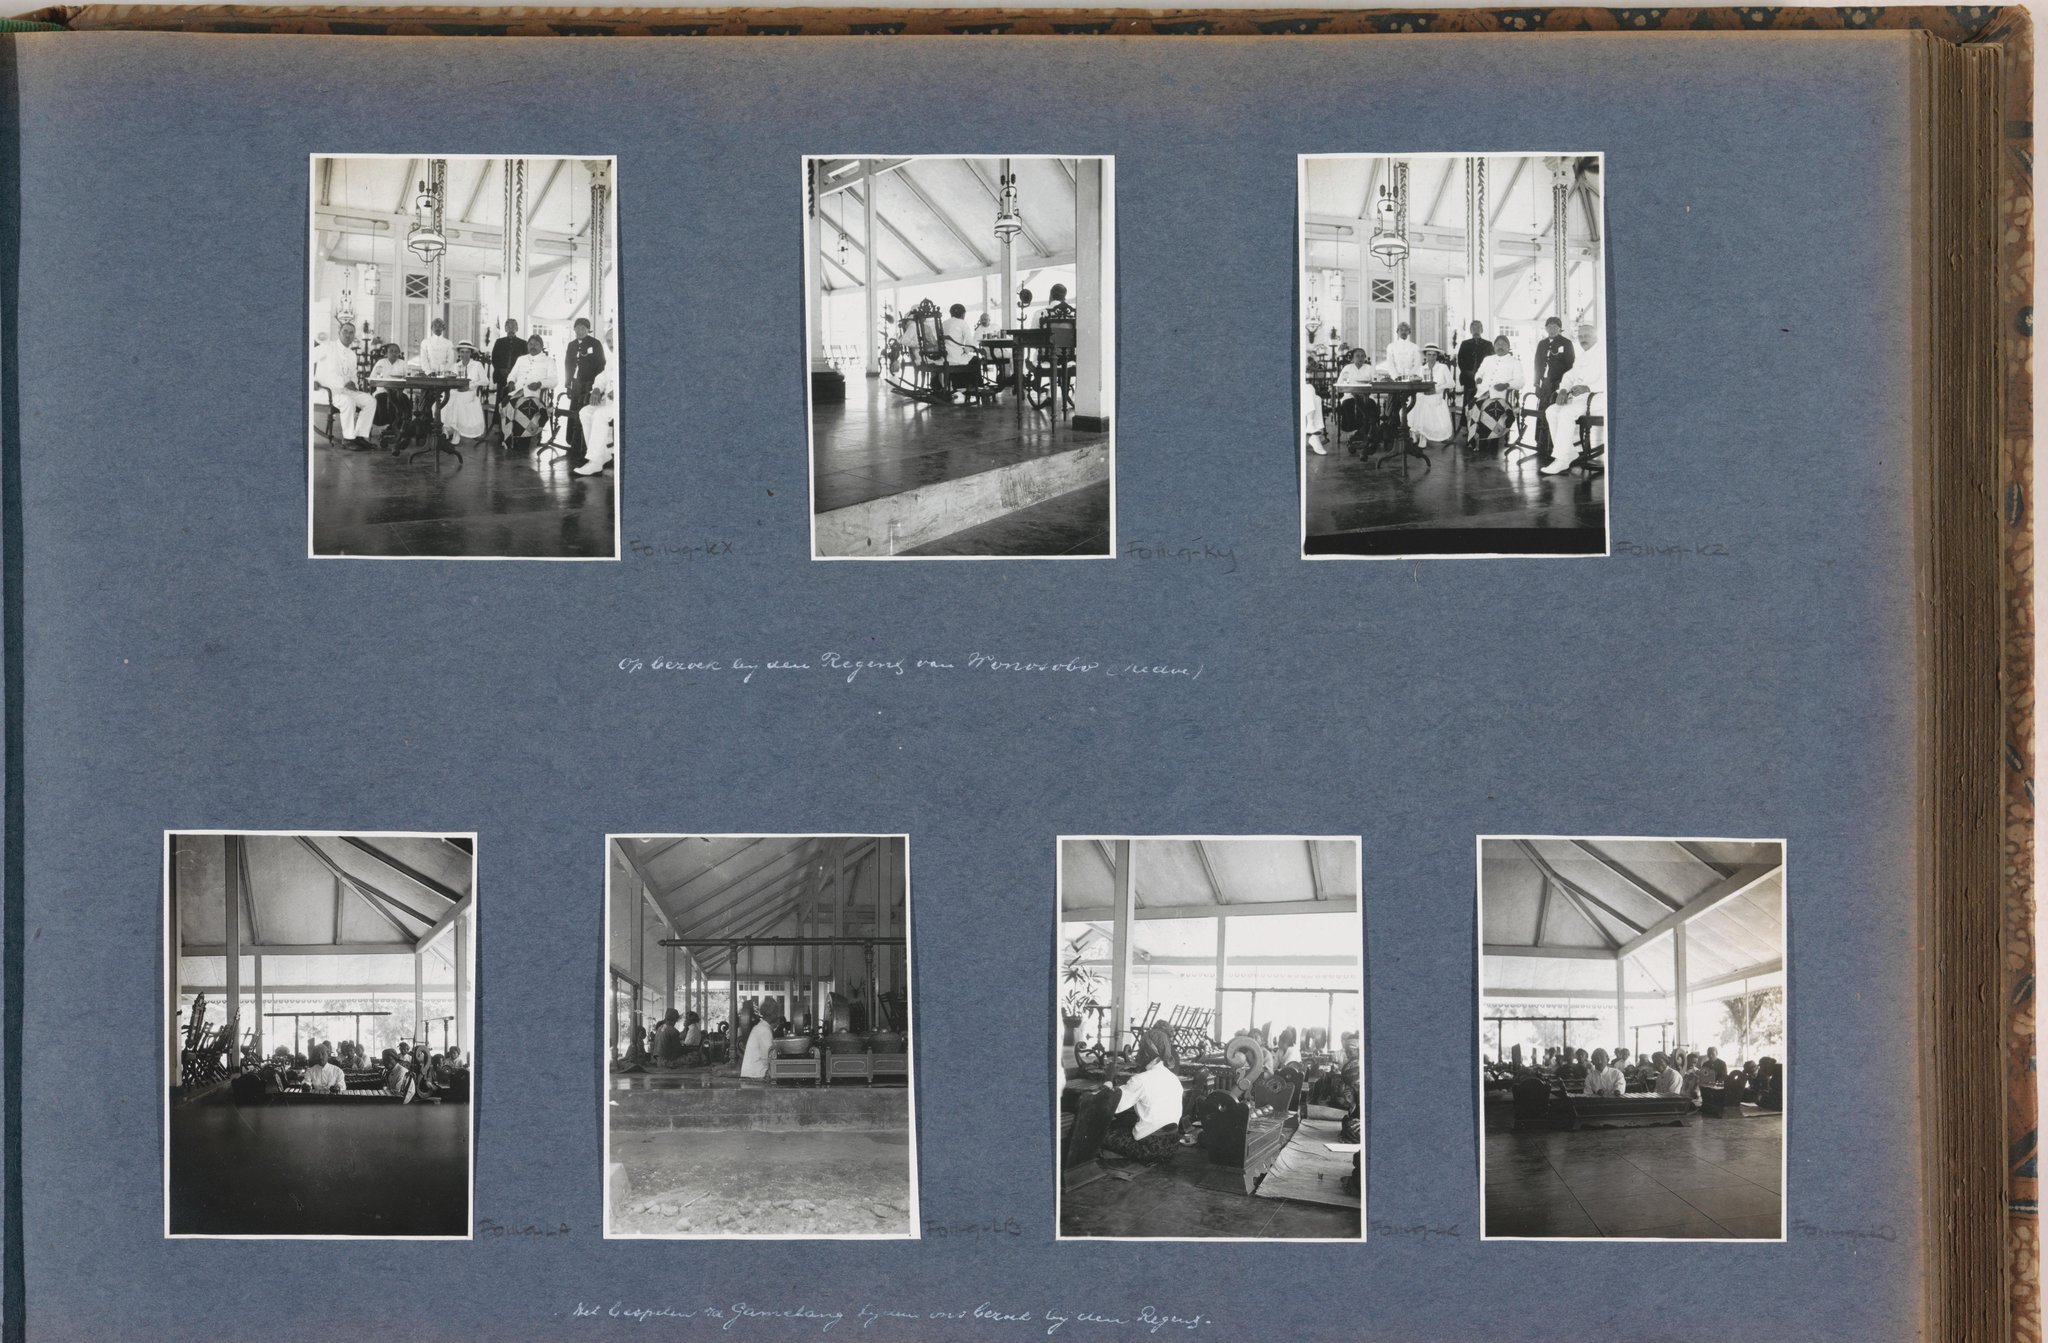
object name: photograph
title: Groepsportret van de regent van Wonosobo, Europese bezoekers en personeel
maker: Anonymous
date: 1900-1920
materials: paper, photographic support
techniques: gelatin silver print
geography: java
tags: interior of the house, ruler, sovereign, java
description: Onderdeel van reisalbum met foto's van bedrijvigheid en bezienswaardigheden op Sumatra en Java en van de reis naar en van Nederlands-Indië.